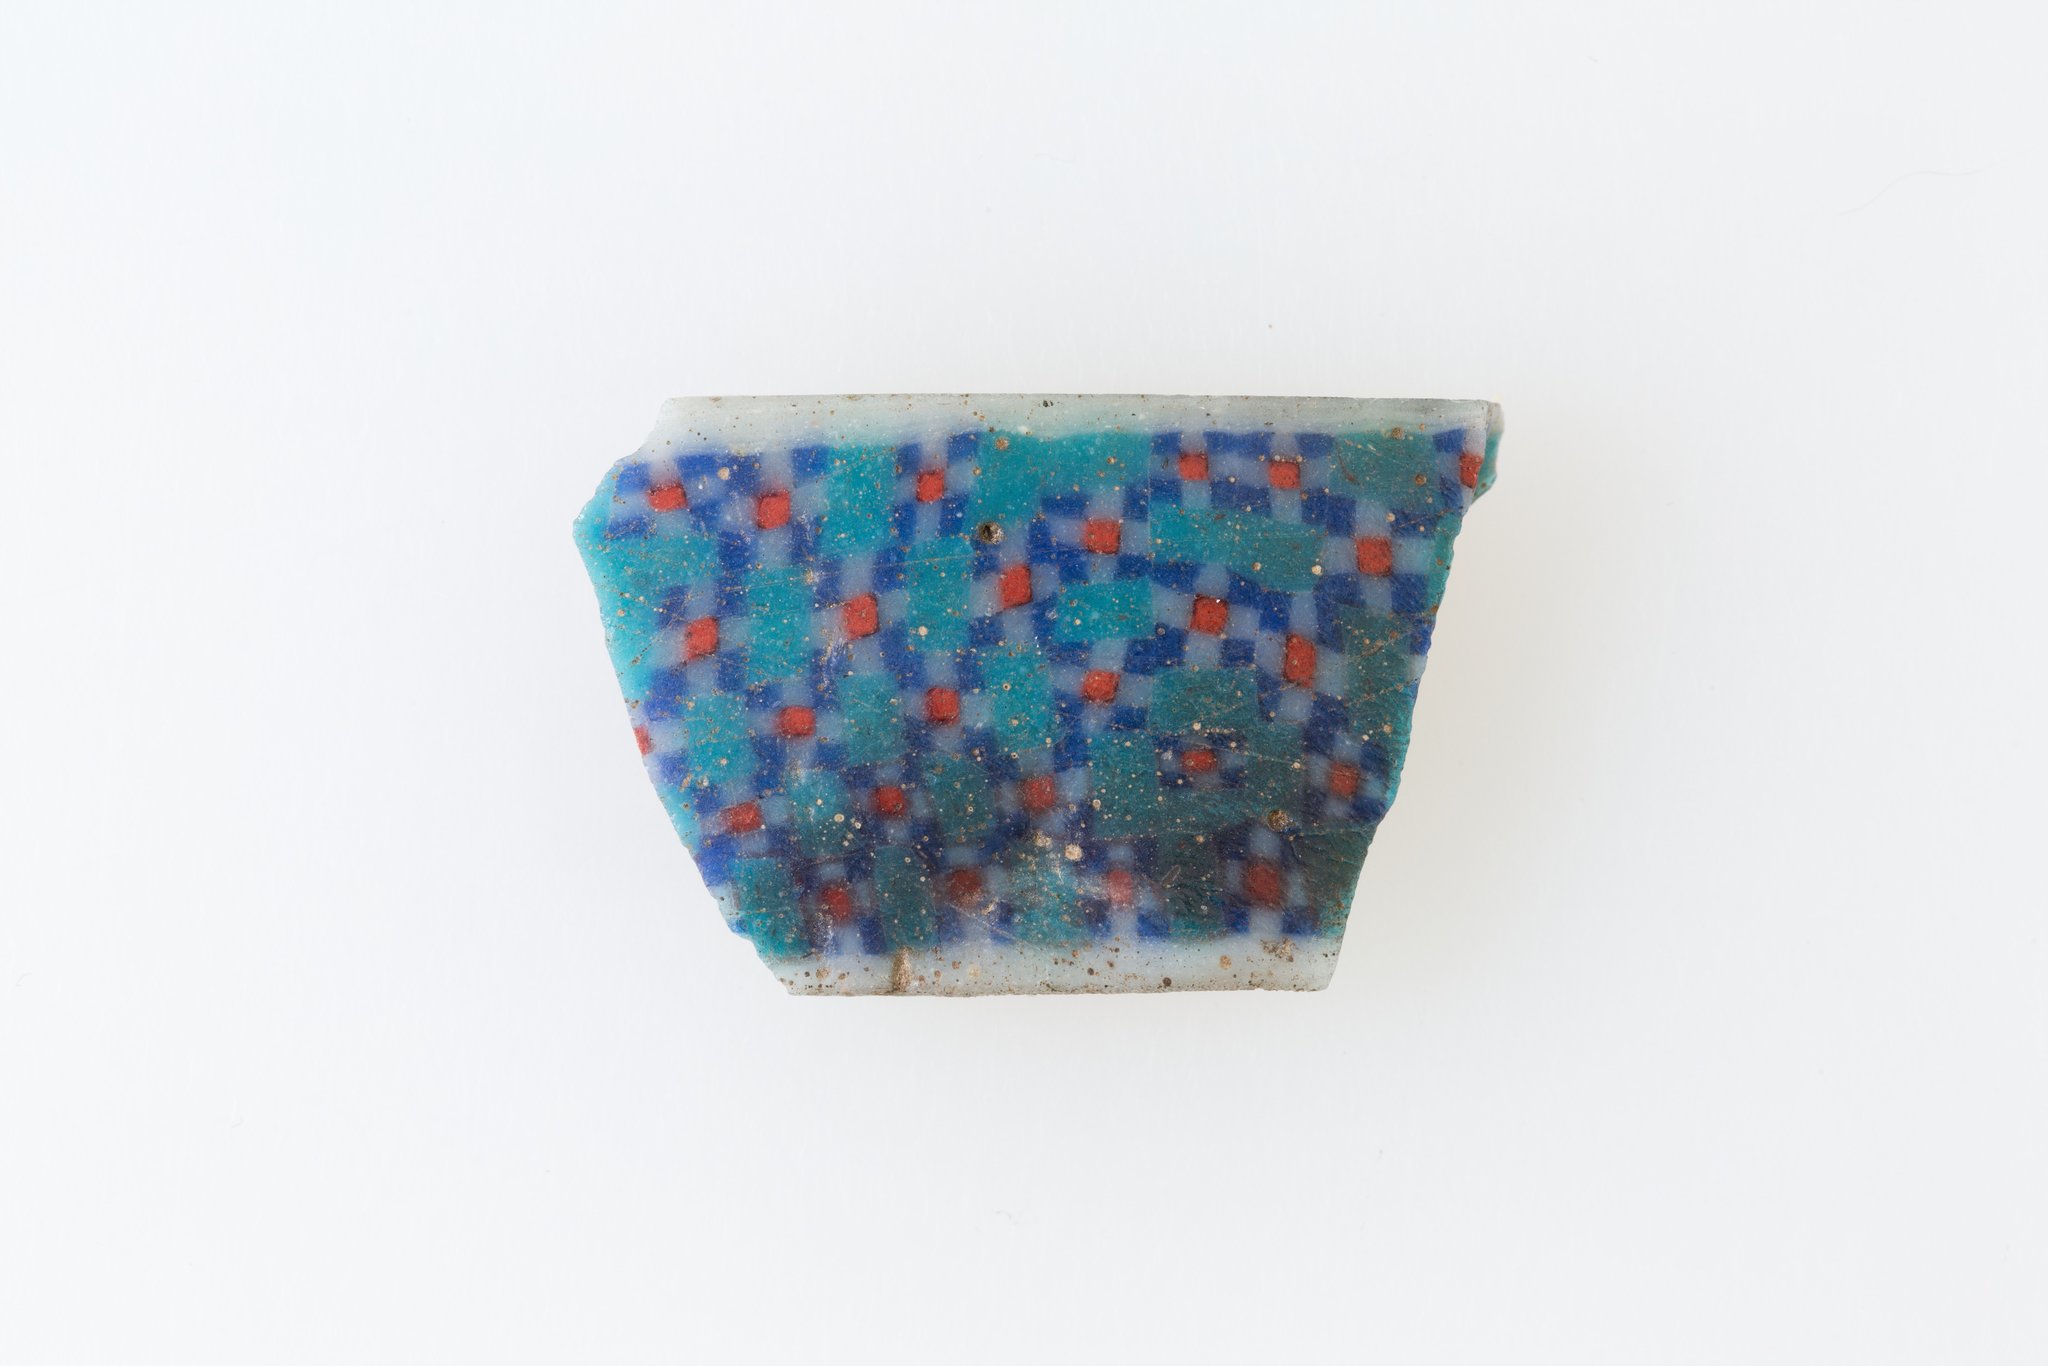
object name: inlay fragment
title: Inlay fragment, patten of diamonds formed from smaller squares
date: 100 BCE-100 CE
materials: glass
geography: egypt